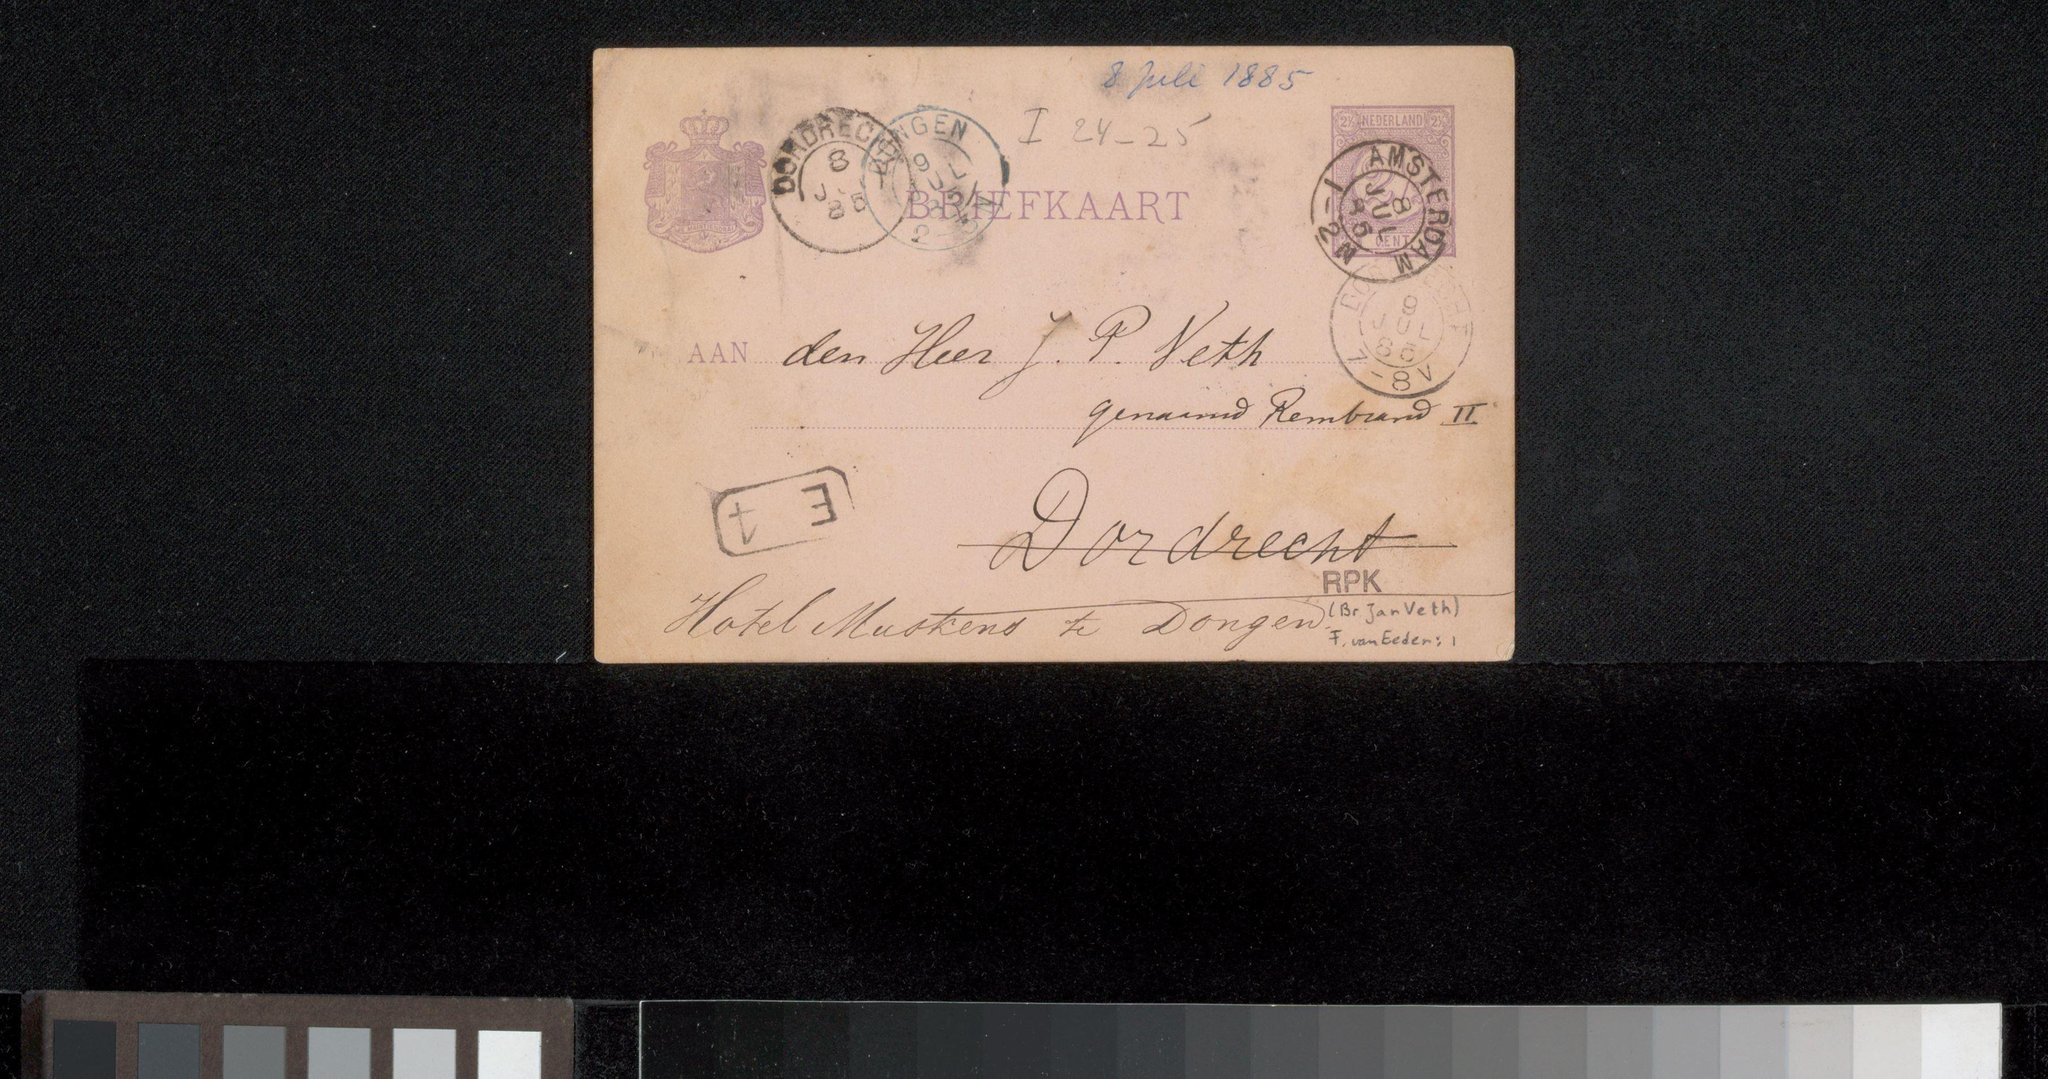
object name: postcard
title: Briefkaart aan Jan Veth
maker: frederik van eeden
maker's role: schrijver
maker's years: 1860-1932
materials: cardboard, ink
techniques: pen, writing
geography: amsterdam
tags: dordrecht, designer, jan veth, haarlem, painter, print maker, draughtsman, jac van looij, the hague, willem kloos, albert verwey, deventer, martha van vloten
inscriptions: collector's mark: ‘RPK’